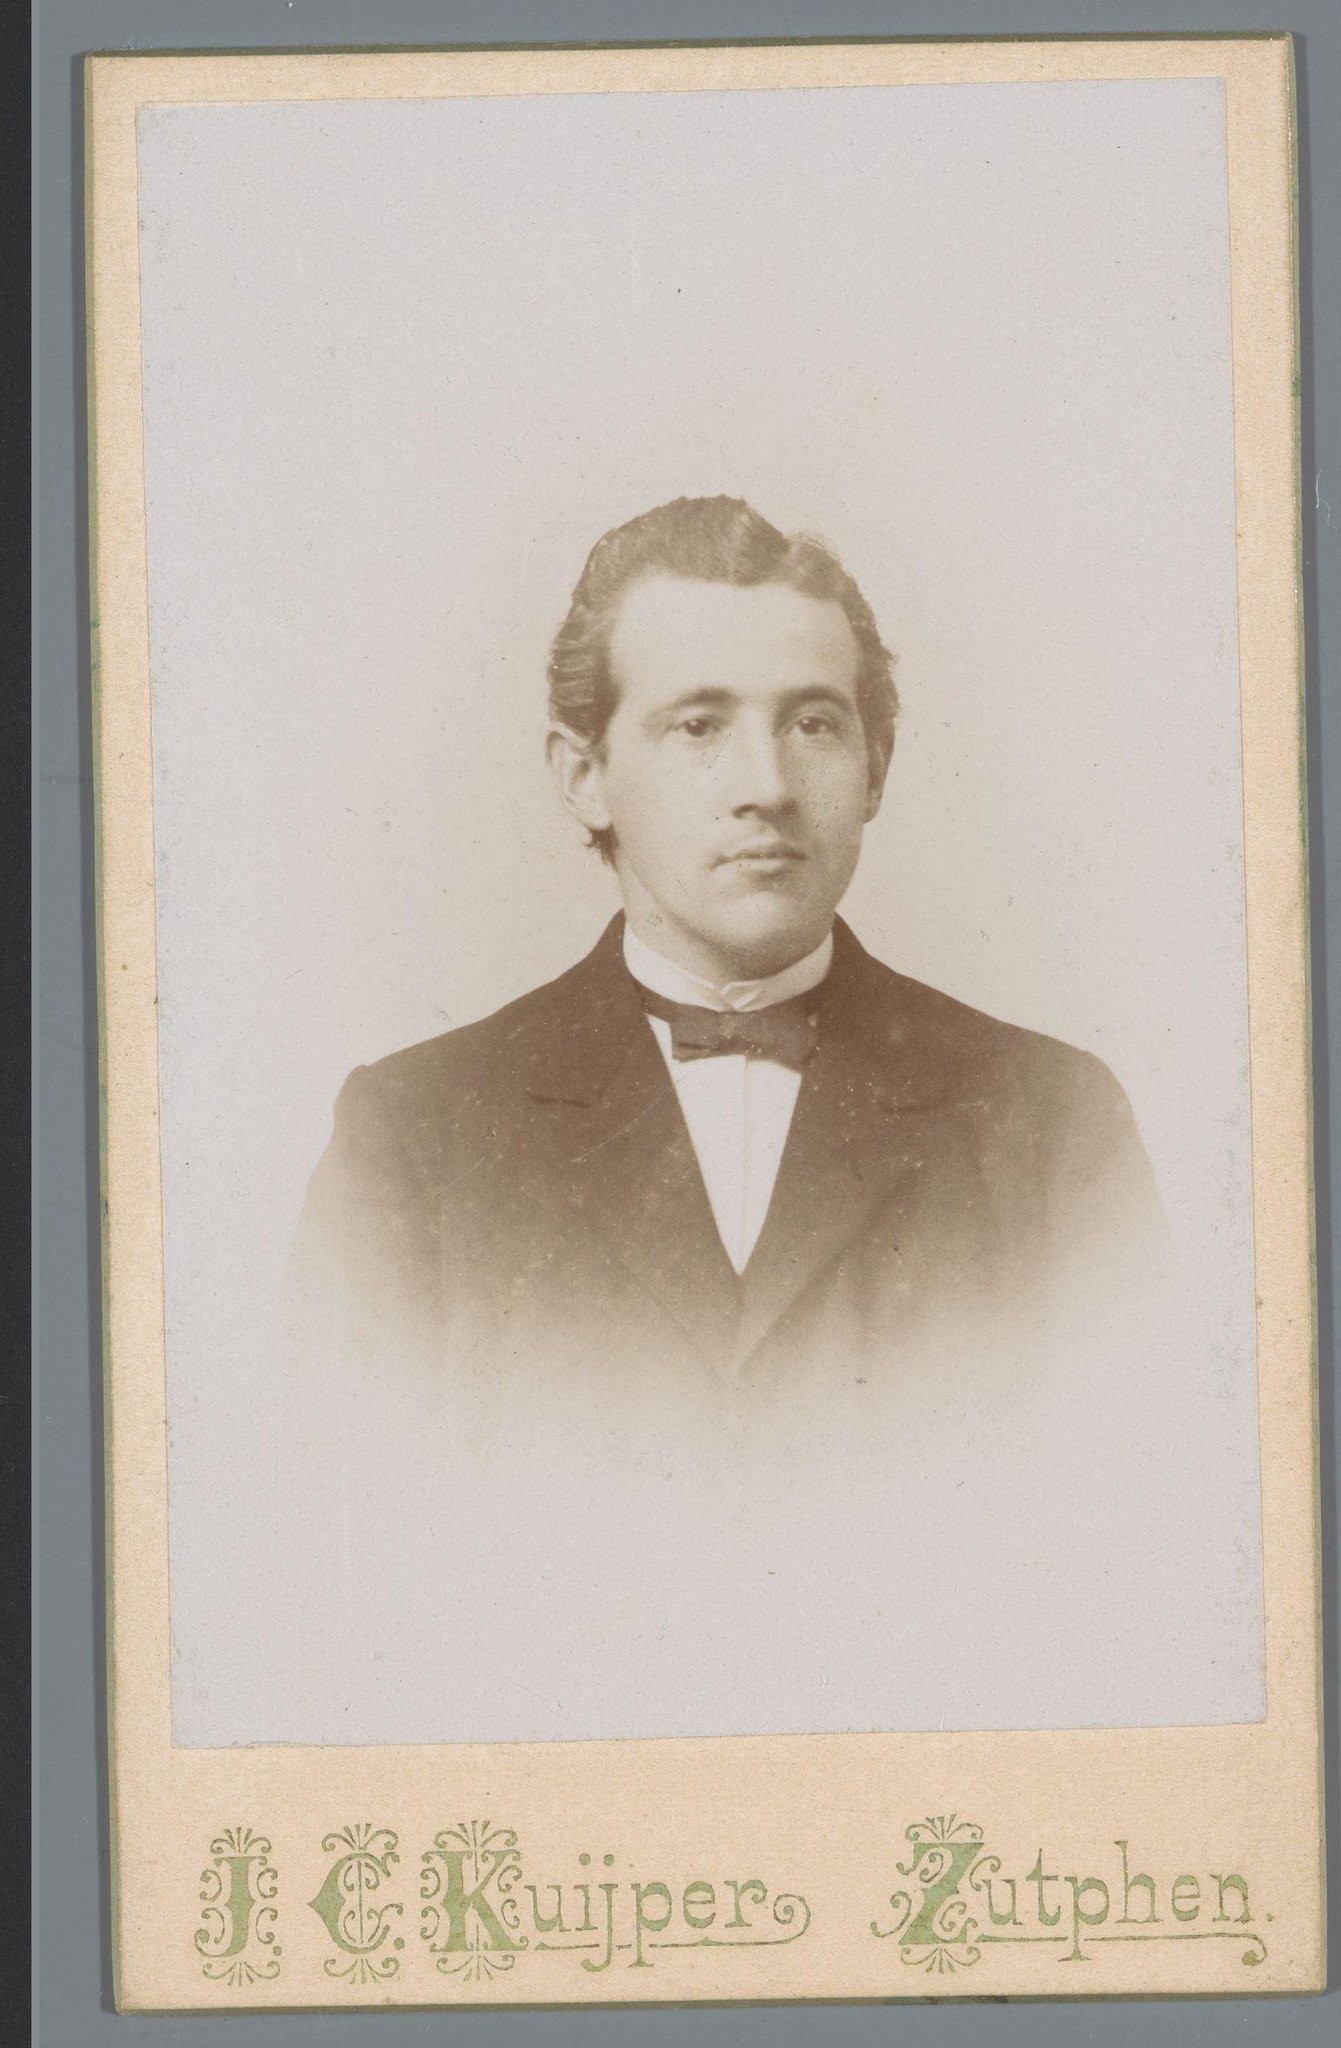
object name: photograph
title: Portret van een onbekende man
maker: jacobus cornelis kuijper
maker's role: fotograaf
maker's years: 1852-1924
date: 1897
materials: paper, cardboard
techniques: collodion silver print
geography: zutphen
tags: adult man, anonymous historical person portrayed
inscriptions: inscription: ‘Specialiteit voor Vergrootingen in onveranderlijke kool-en Platinadruk./ Het cliché blijft voor nabestelling bewaard./ 'BLOCK & CO. BERLIN S.W. 13.’, address: ‘Boompjeswal en/ Bornhovestraat E. 141./ Zutphen.’